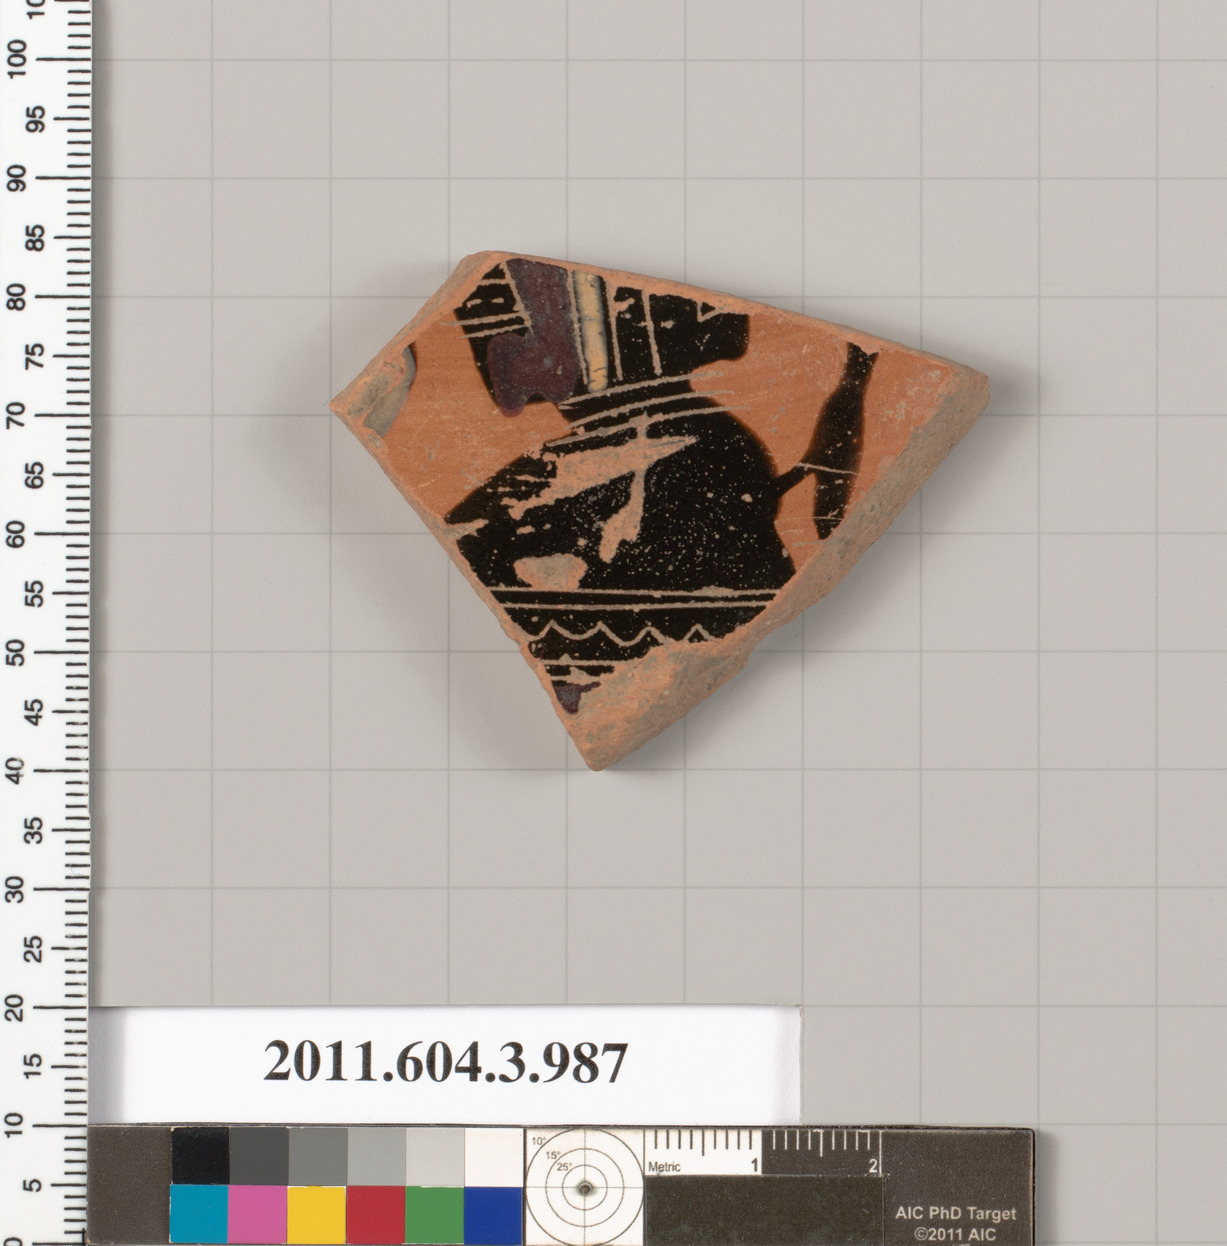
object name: lekanis lid fragment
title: Terracotta fragment of a lekanis lid (covered dish)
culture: greek, attic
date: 575-551 BCE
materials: terracotta